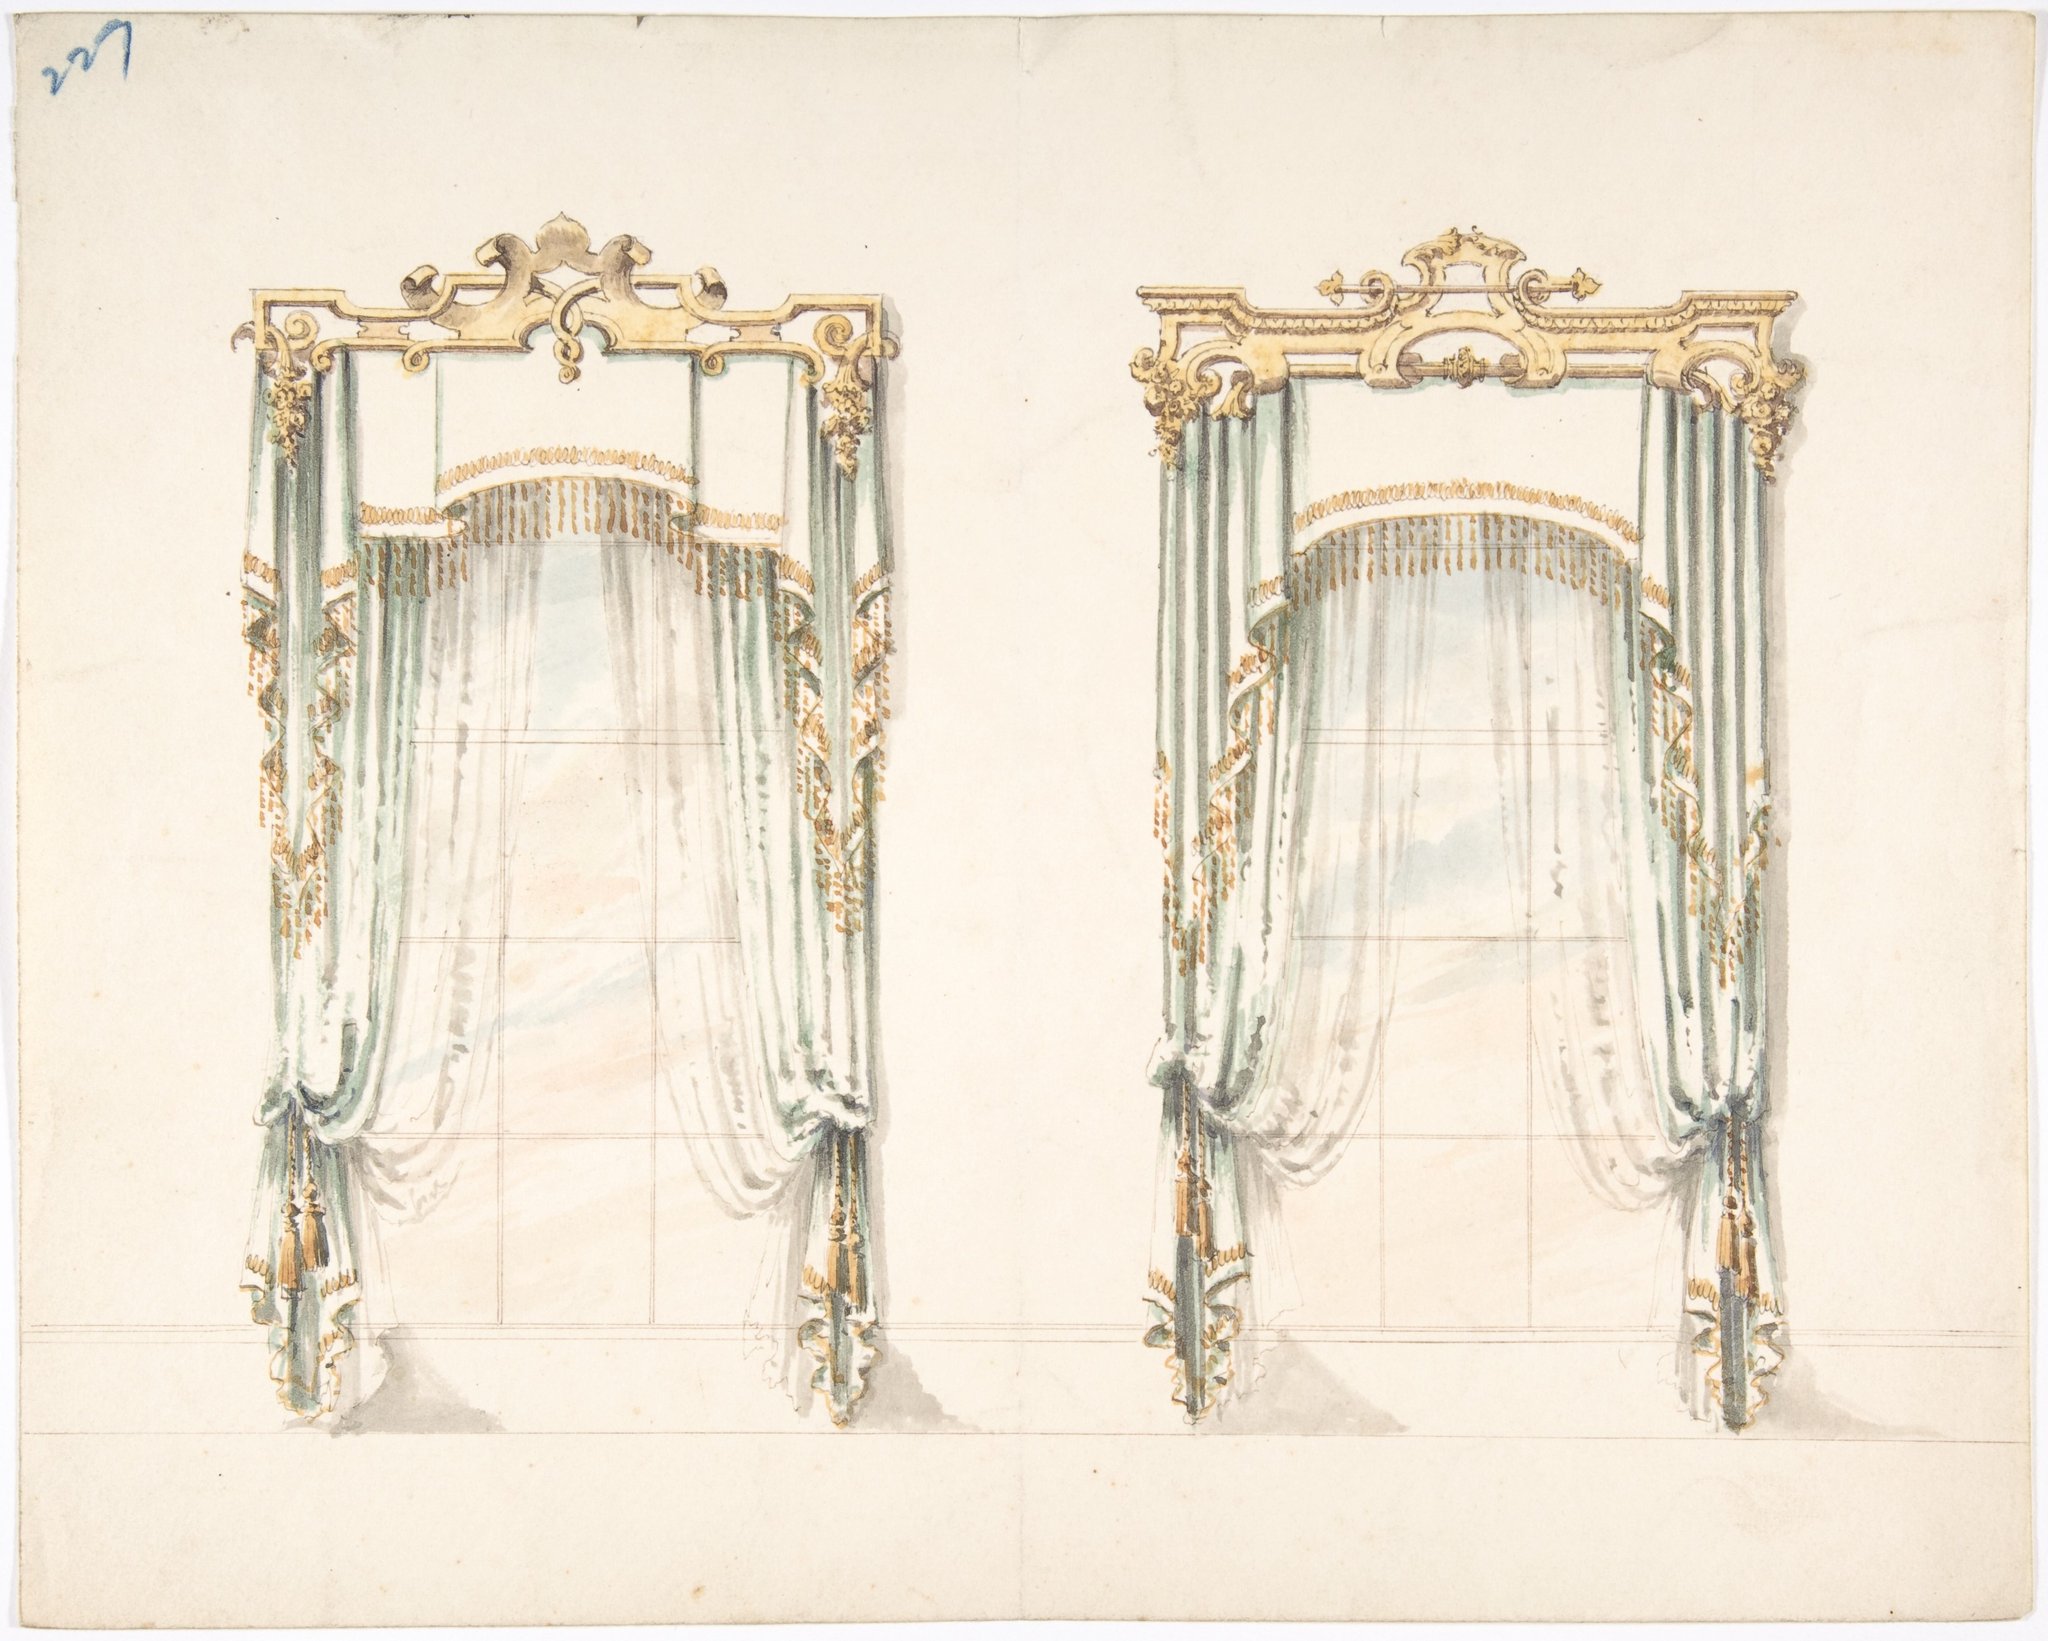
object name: drawing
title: Design for Two White Curtains with Gold Fringes and a White and Gold Pelmets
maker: anonymous, british, 19th century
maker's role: artist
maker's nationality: british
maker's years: 1800-1900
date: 1801-1833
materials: ink, watercolor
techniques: brush, pen, wash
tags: curtains